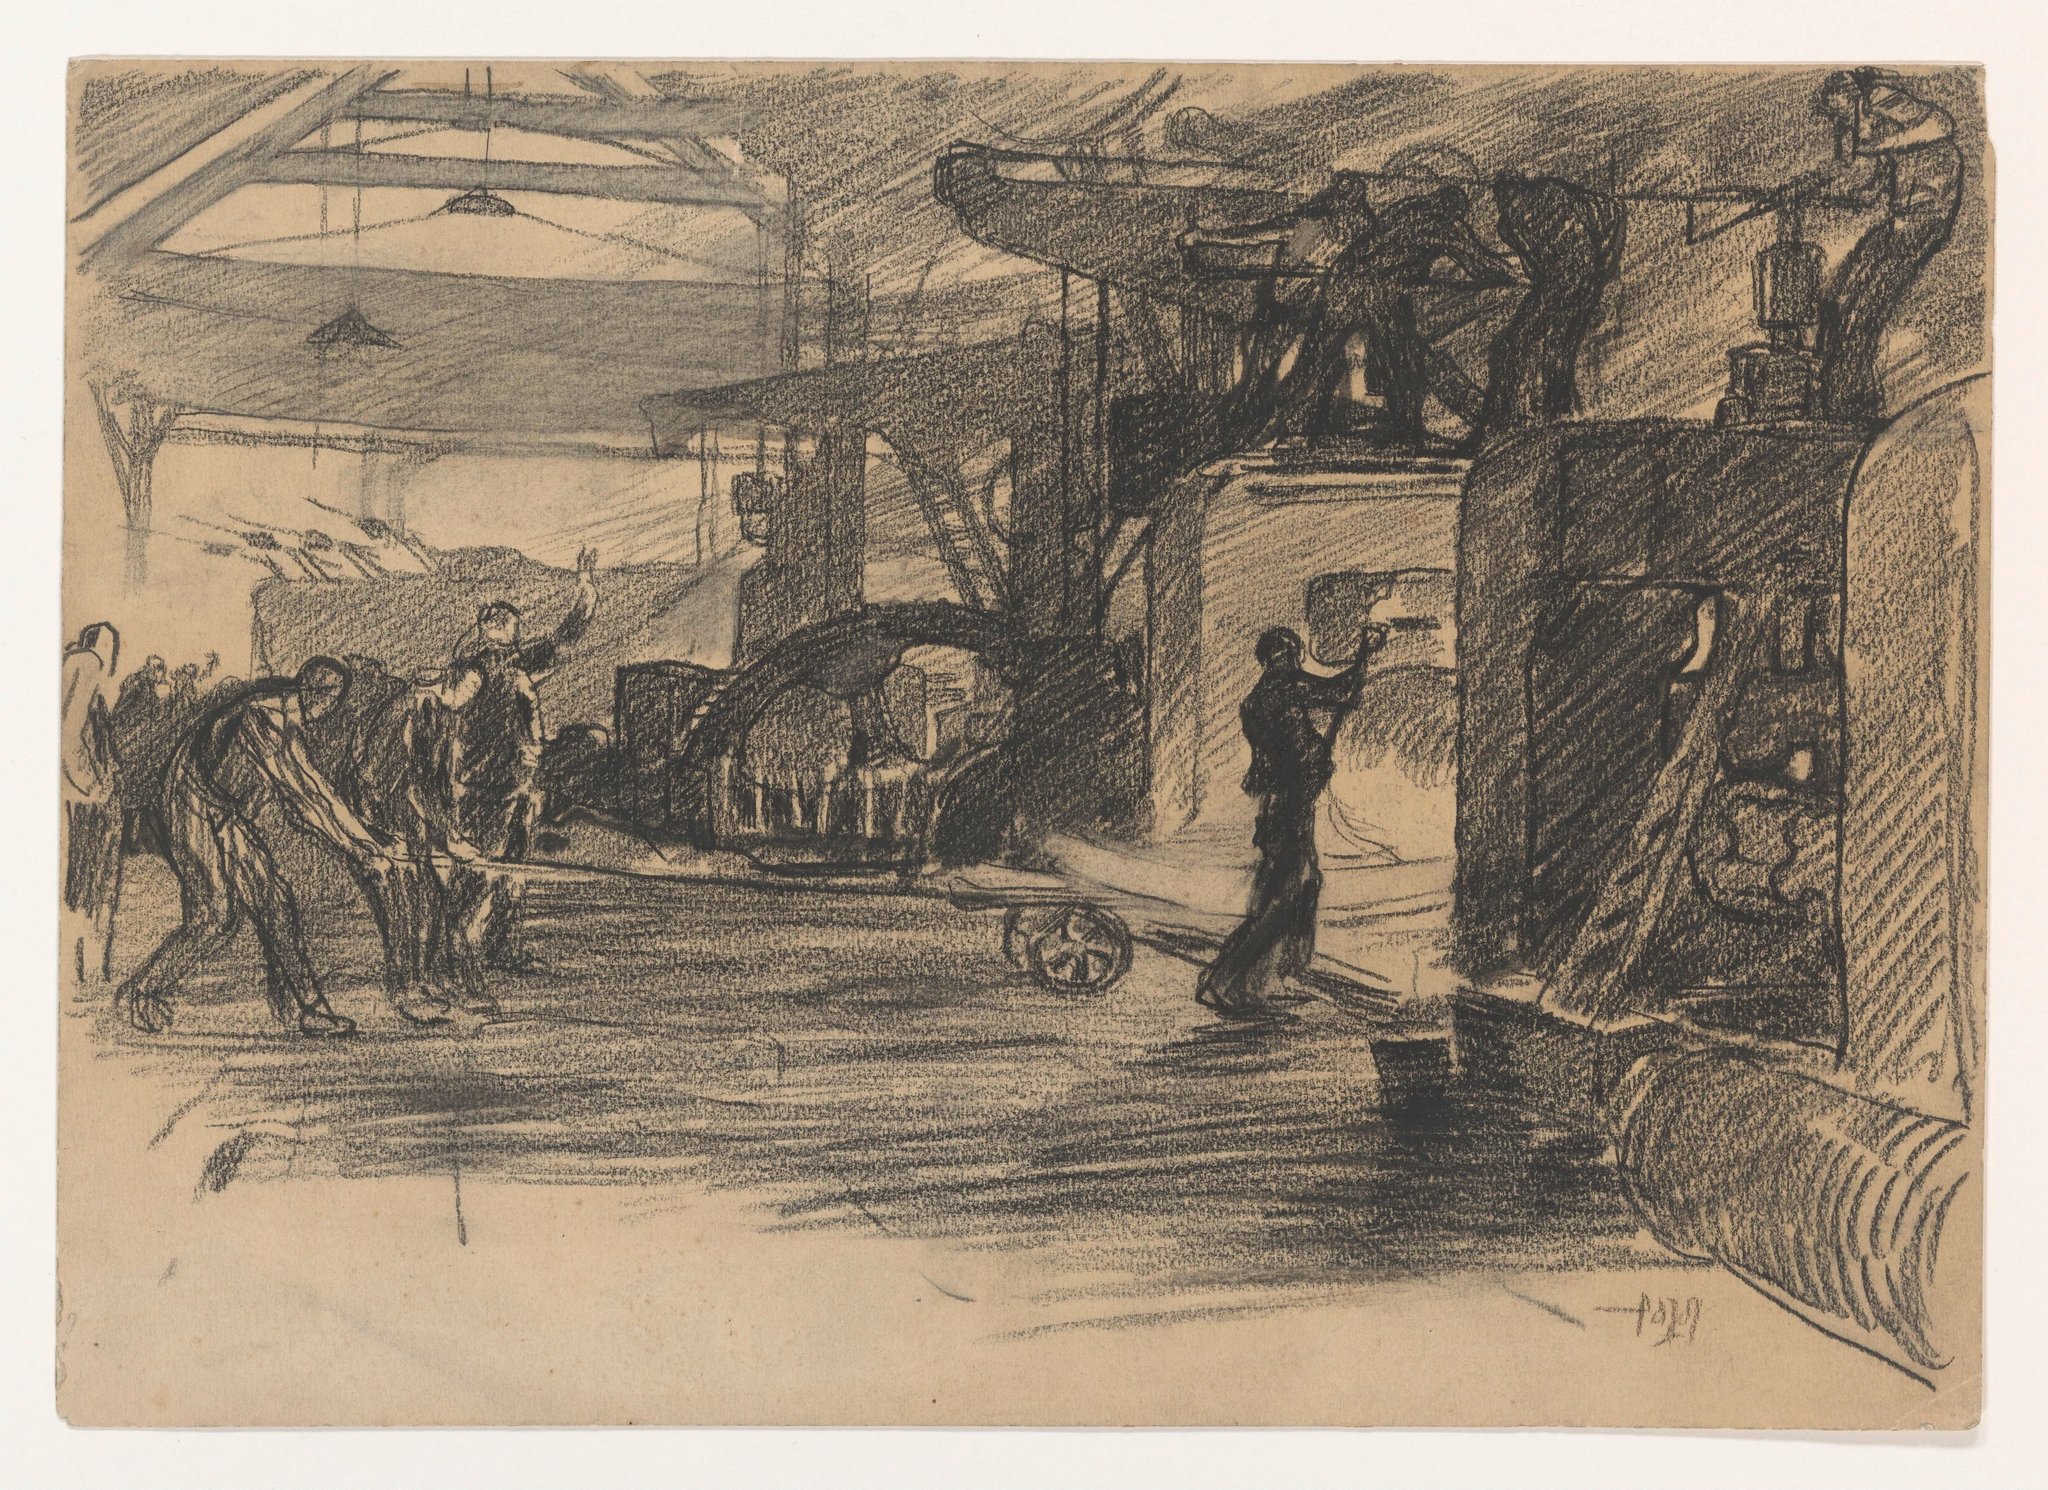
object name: drawing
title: Walswerk in een staalfabriek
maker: pieter de josselin de jong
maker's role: draughtsman, painter, print maker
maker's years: 1861-1906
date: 1871-1906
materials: chalk, paper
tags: heavy industry, blast-furnace